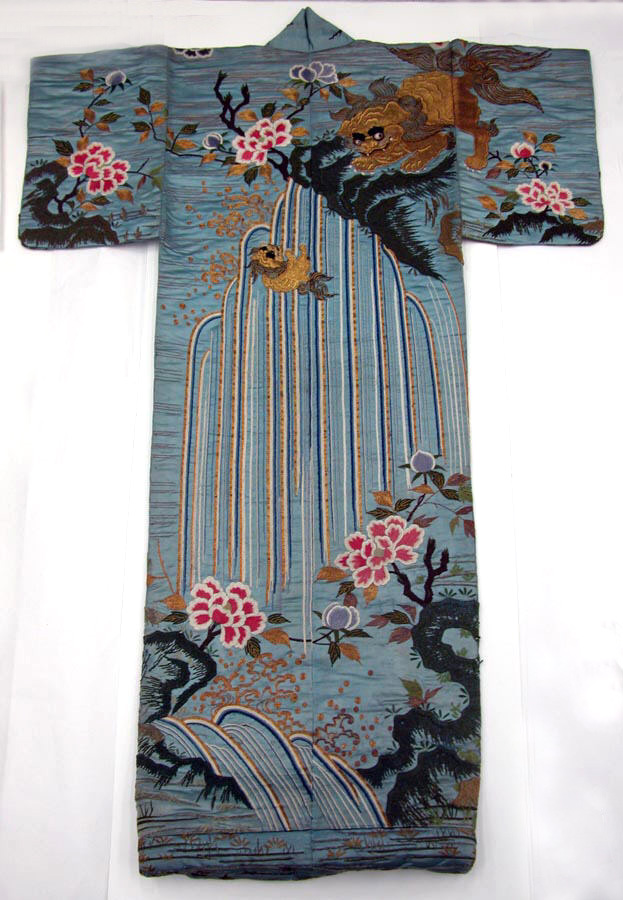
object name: kabuki costume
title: Kabuki Costume: Outer Robe (Uchikake) with Design of Lioness and Cubs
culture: japanese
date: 1851-1900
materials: cotton, glass, metal thread, textile, silk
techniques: embroidery